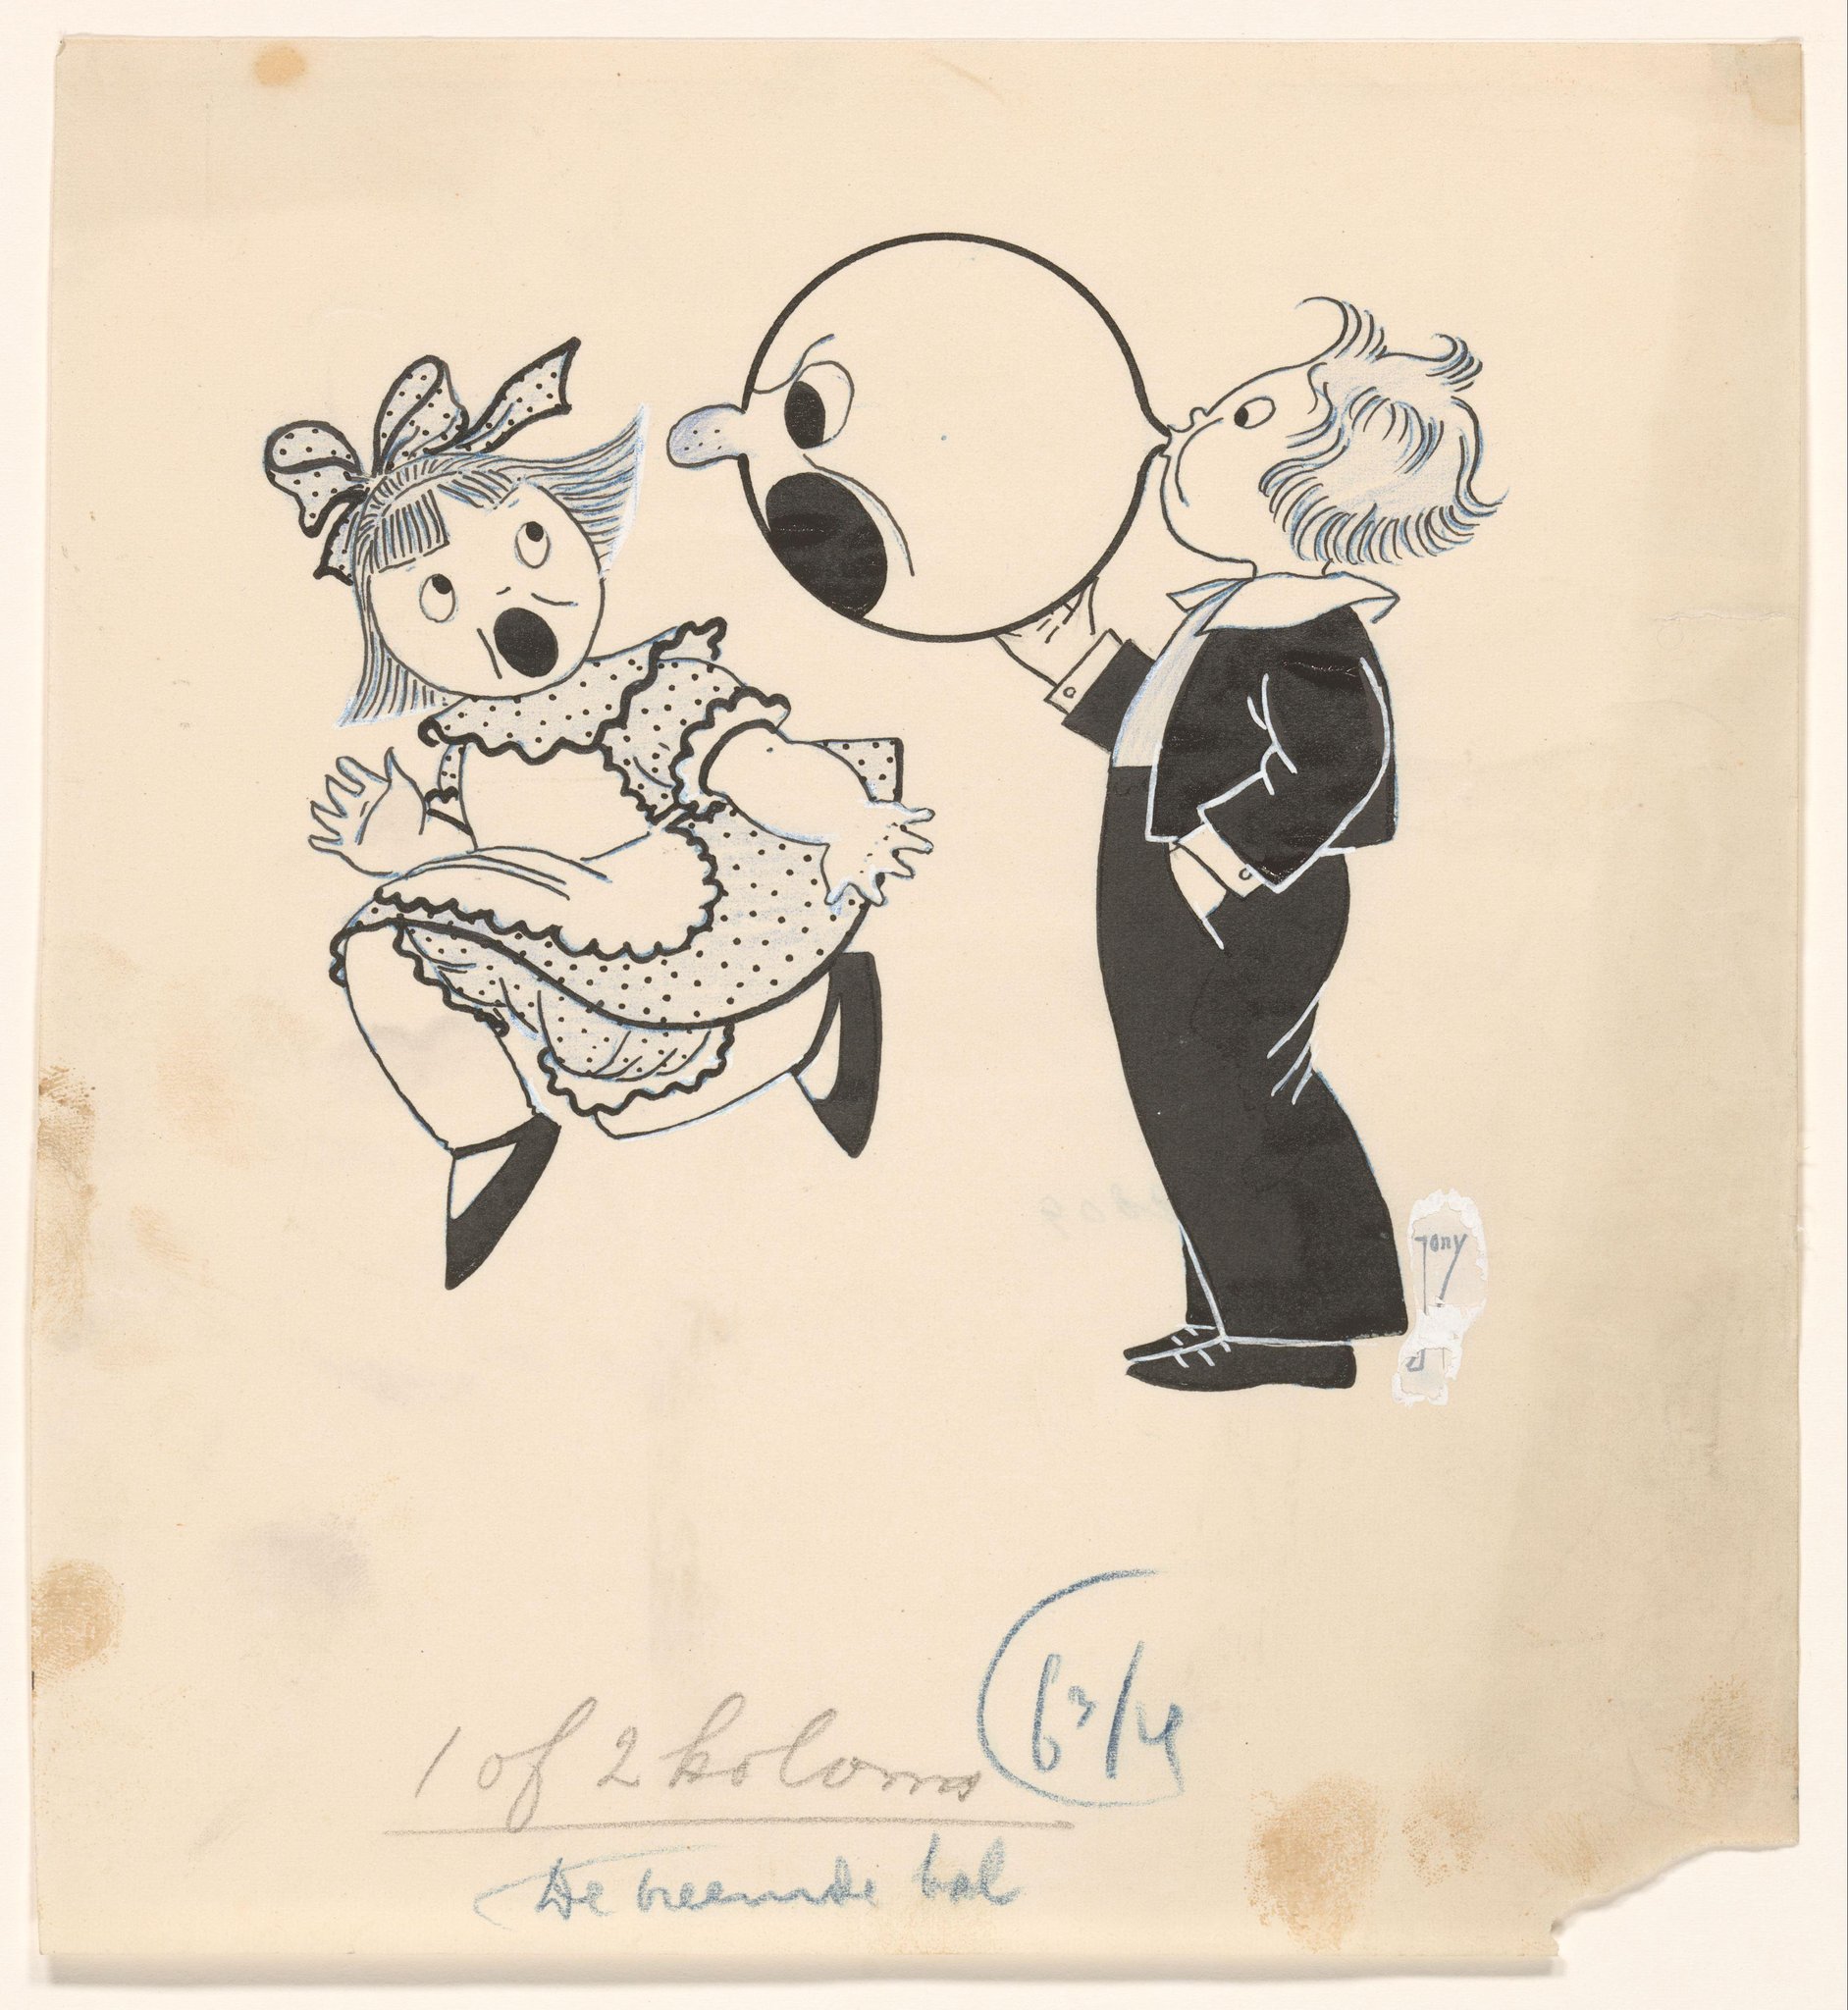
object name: illustratie ontwerp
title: Meisje schrikt van een ballon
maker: jony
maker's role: draughtsman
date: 1875-1925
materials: paint, ink, paper, pencil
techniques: brush, pen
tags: (flying a) gas balloon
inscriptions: annotation: ‘De vreemde bal’, :, signature: ‘Jony’, collector's mark: Lugt 2228a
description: Een jongen blaast een ballon op die de vorm heeft van een gezicht met opengesperde mond. Een meisje kijkt naar de ballon en maakt een sprong van schrik.